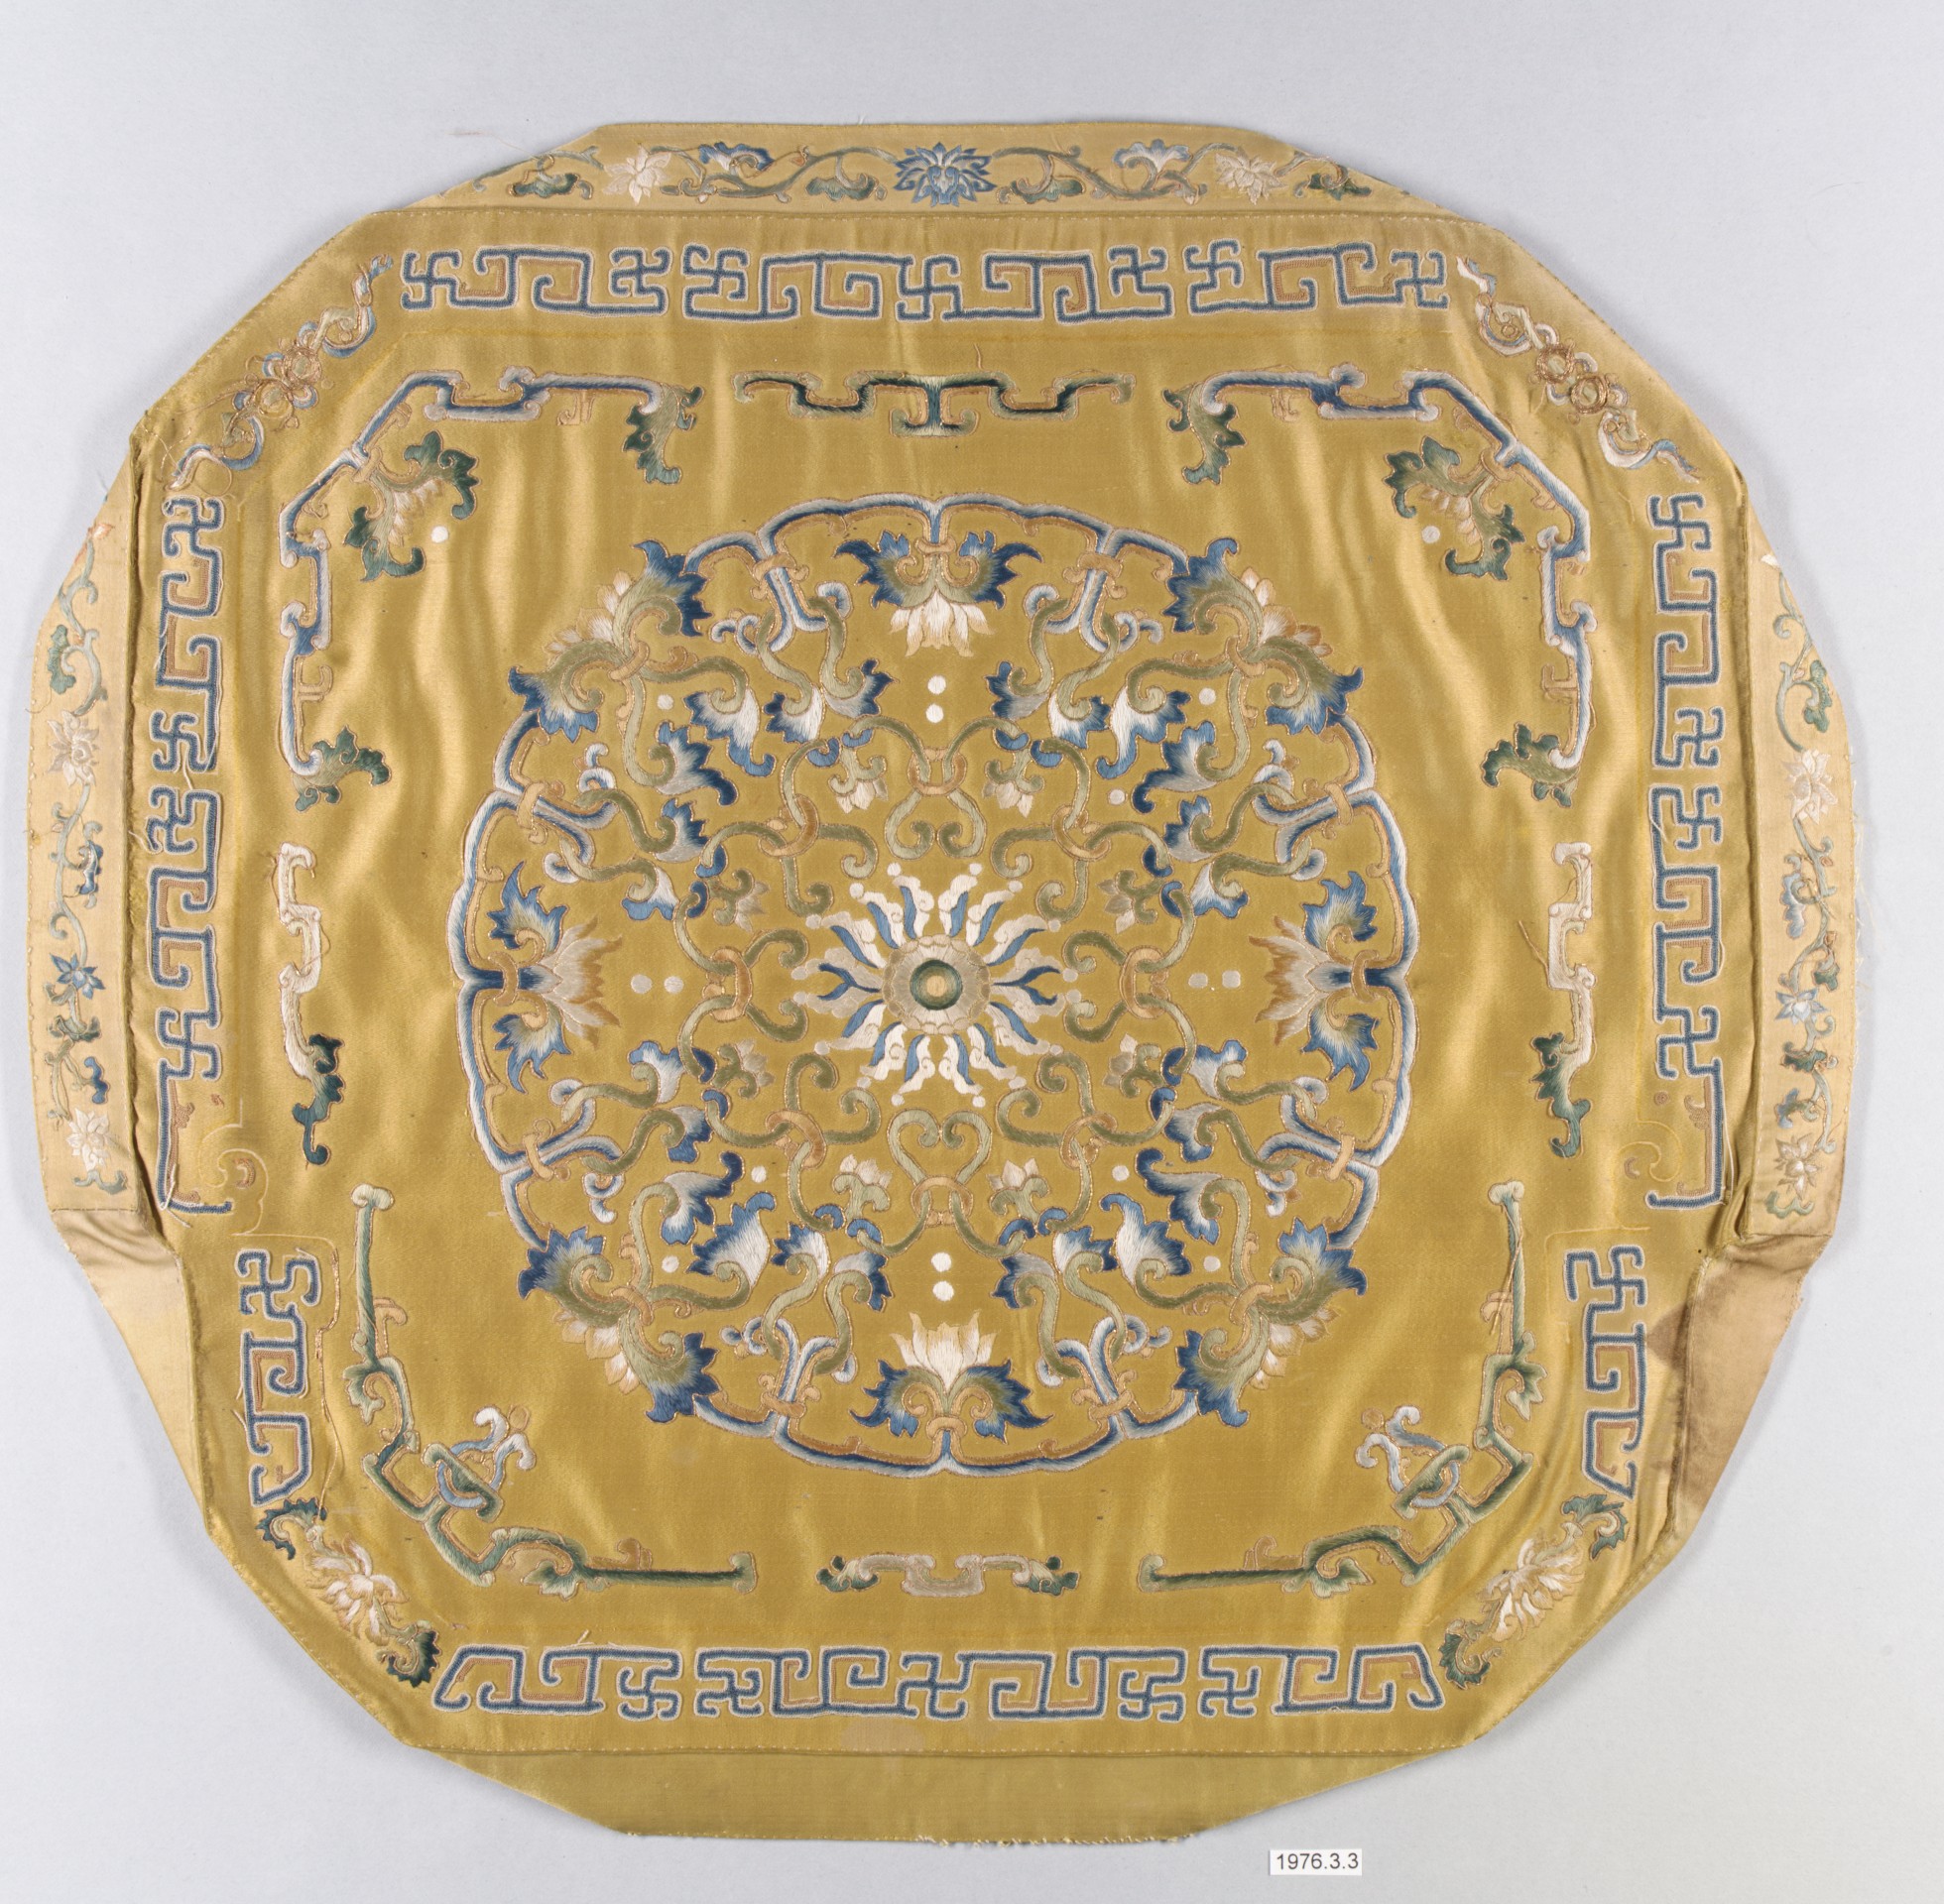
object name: cushion cover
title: Cushion Cover for Chair Pad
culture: chinese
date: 1736-1795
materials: metal thread, silk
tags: flowers